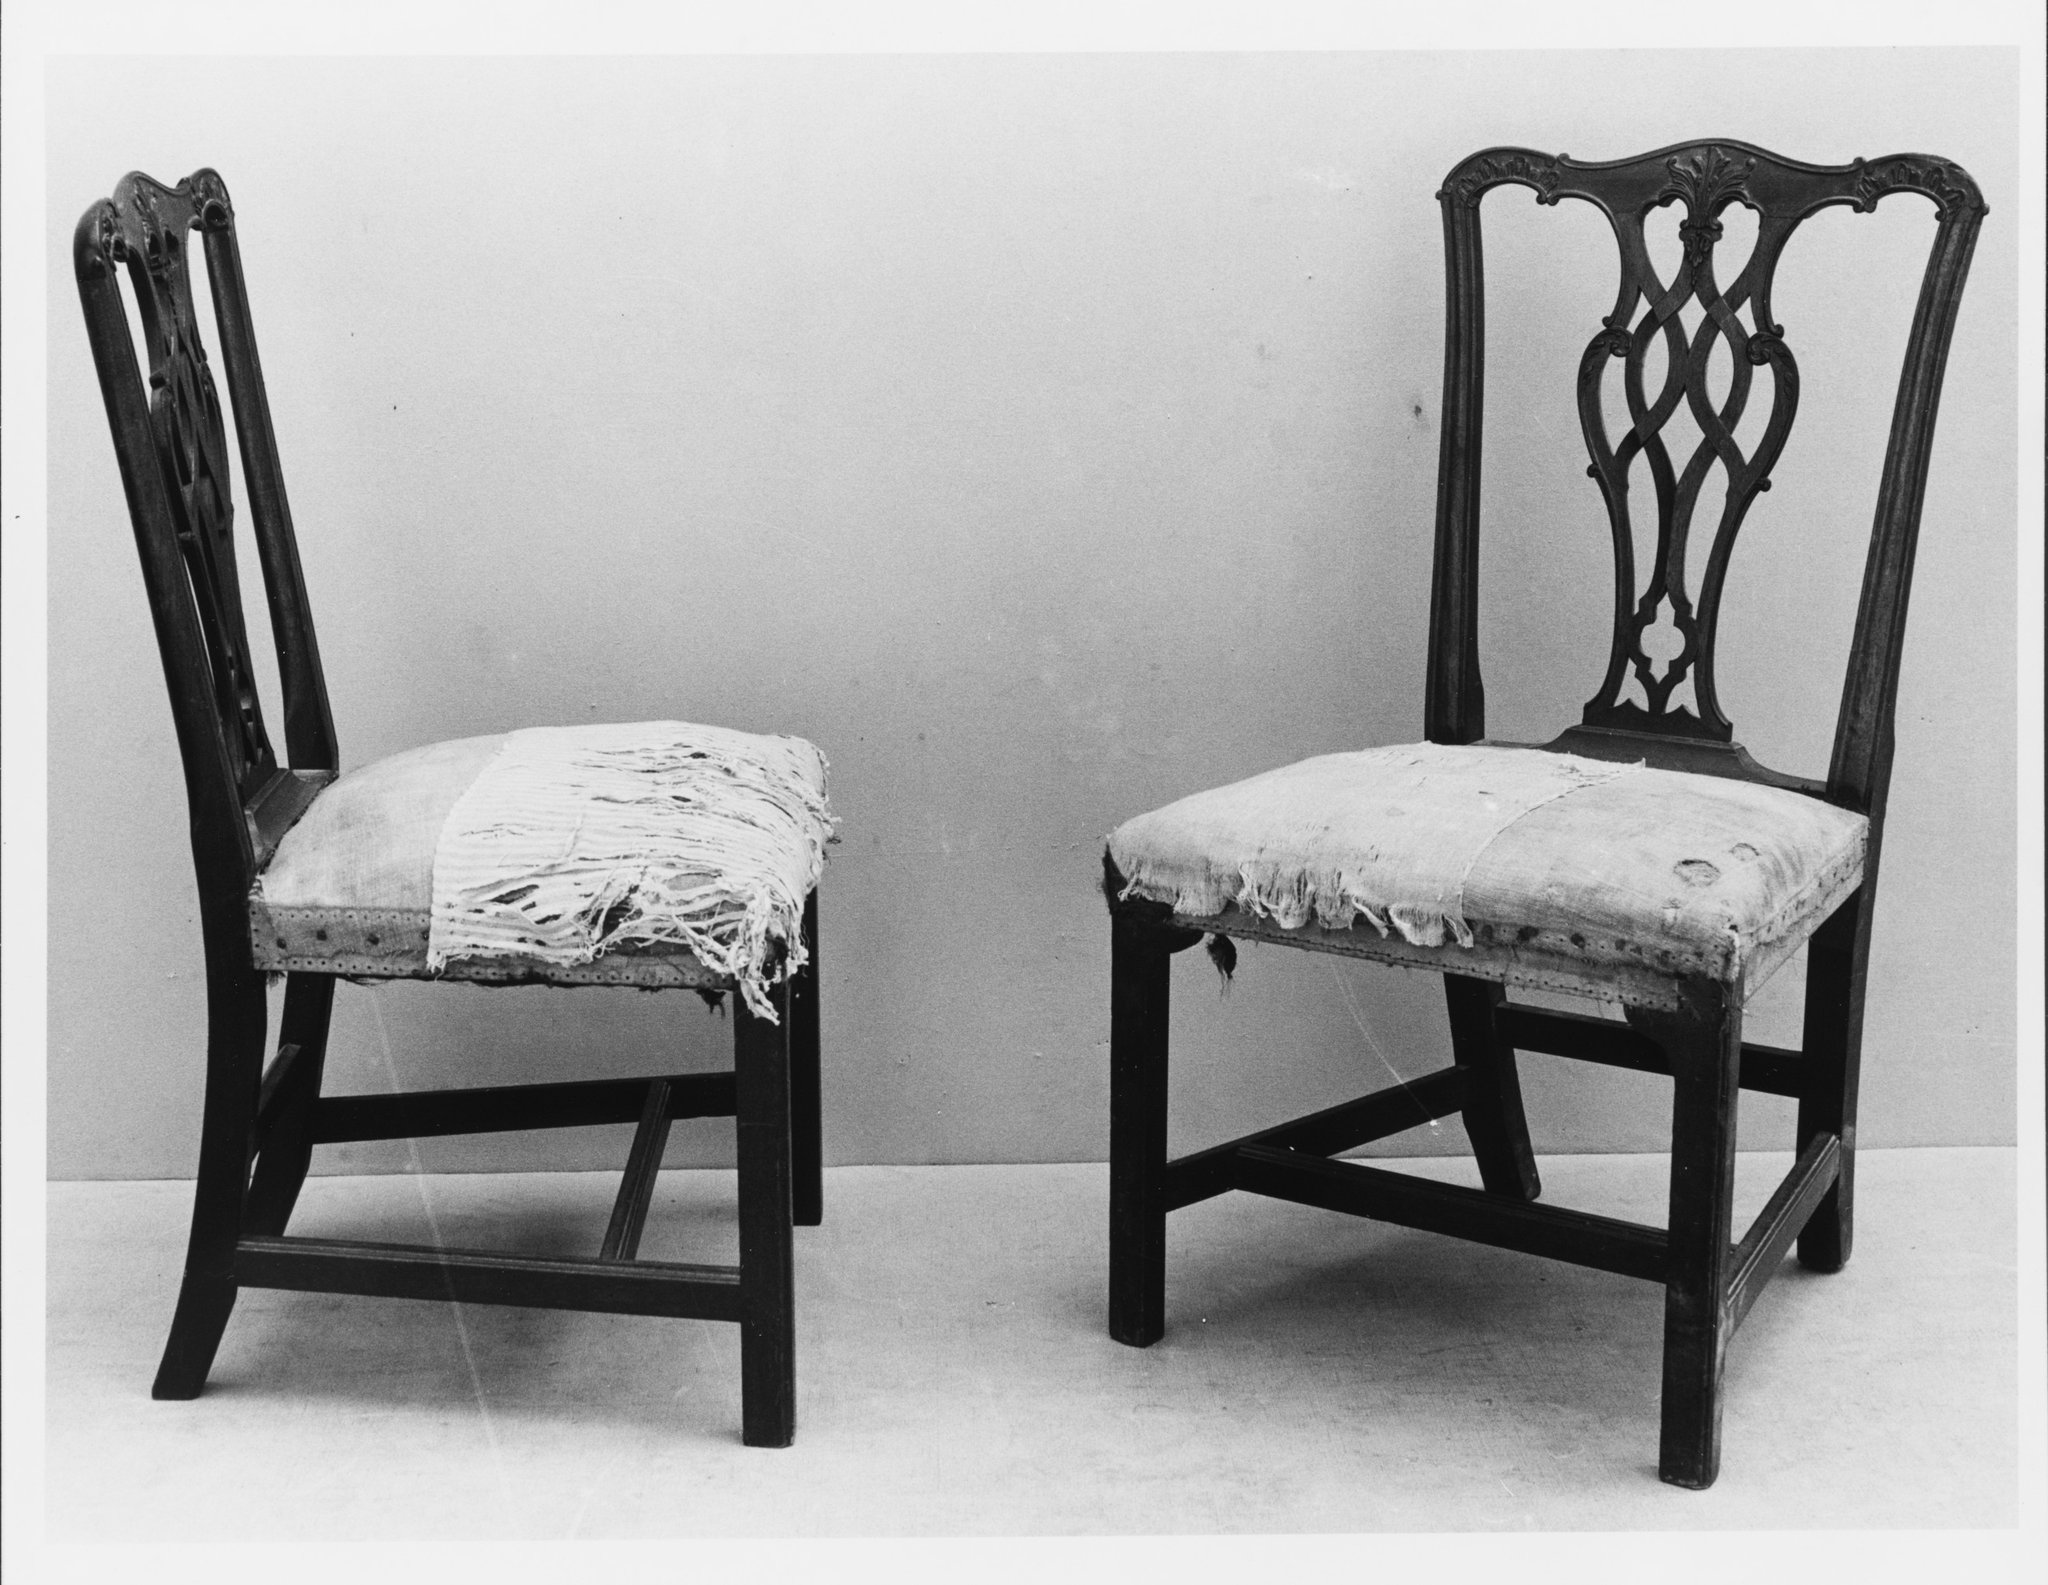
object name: side chair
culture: american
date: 1760-1790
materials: wood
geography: united states